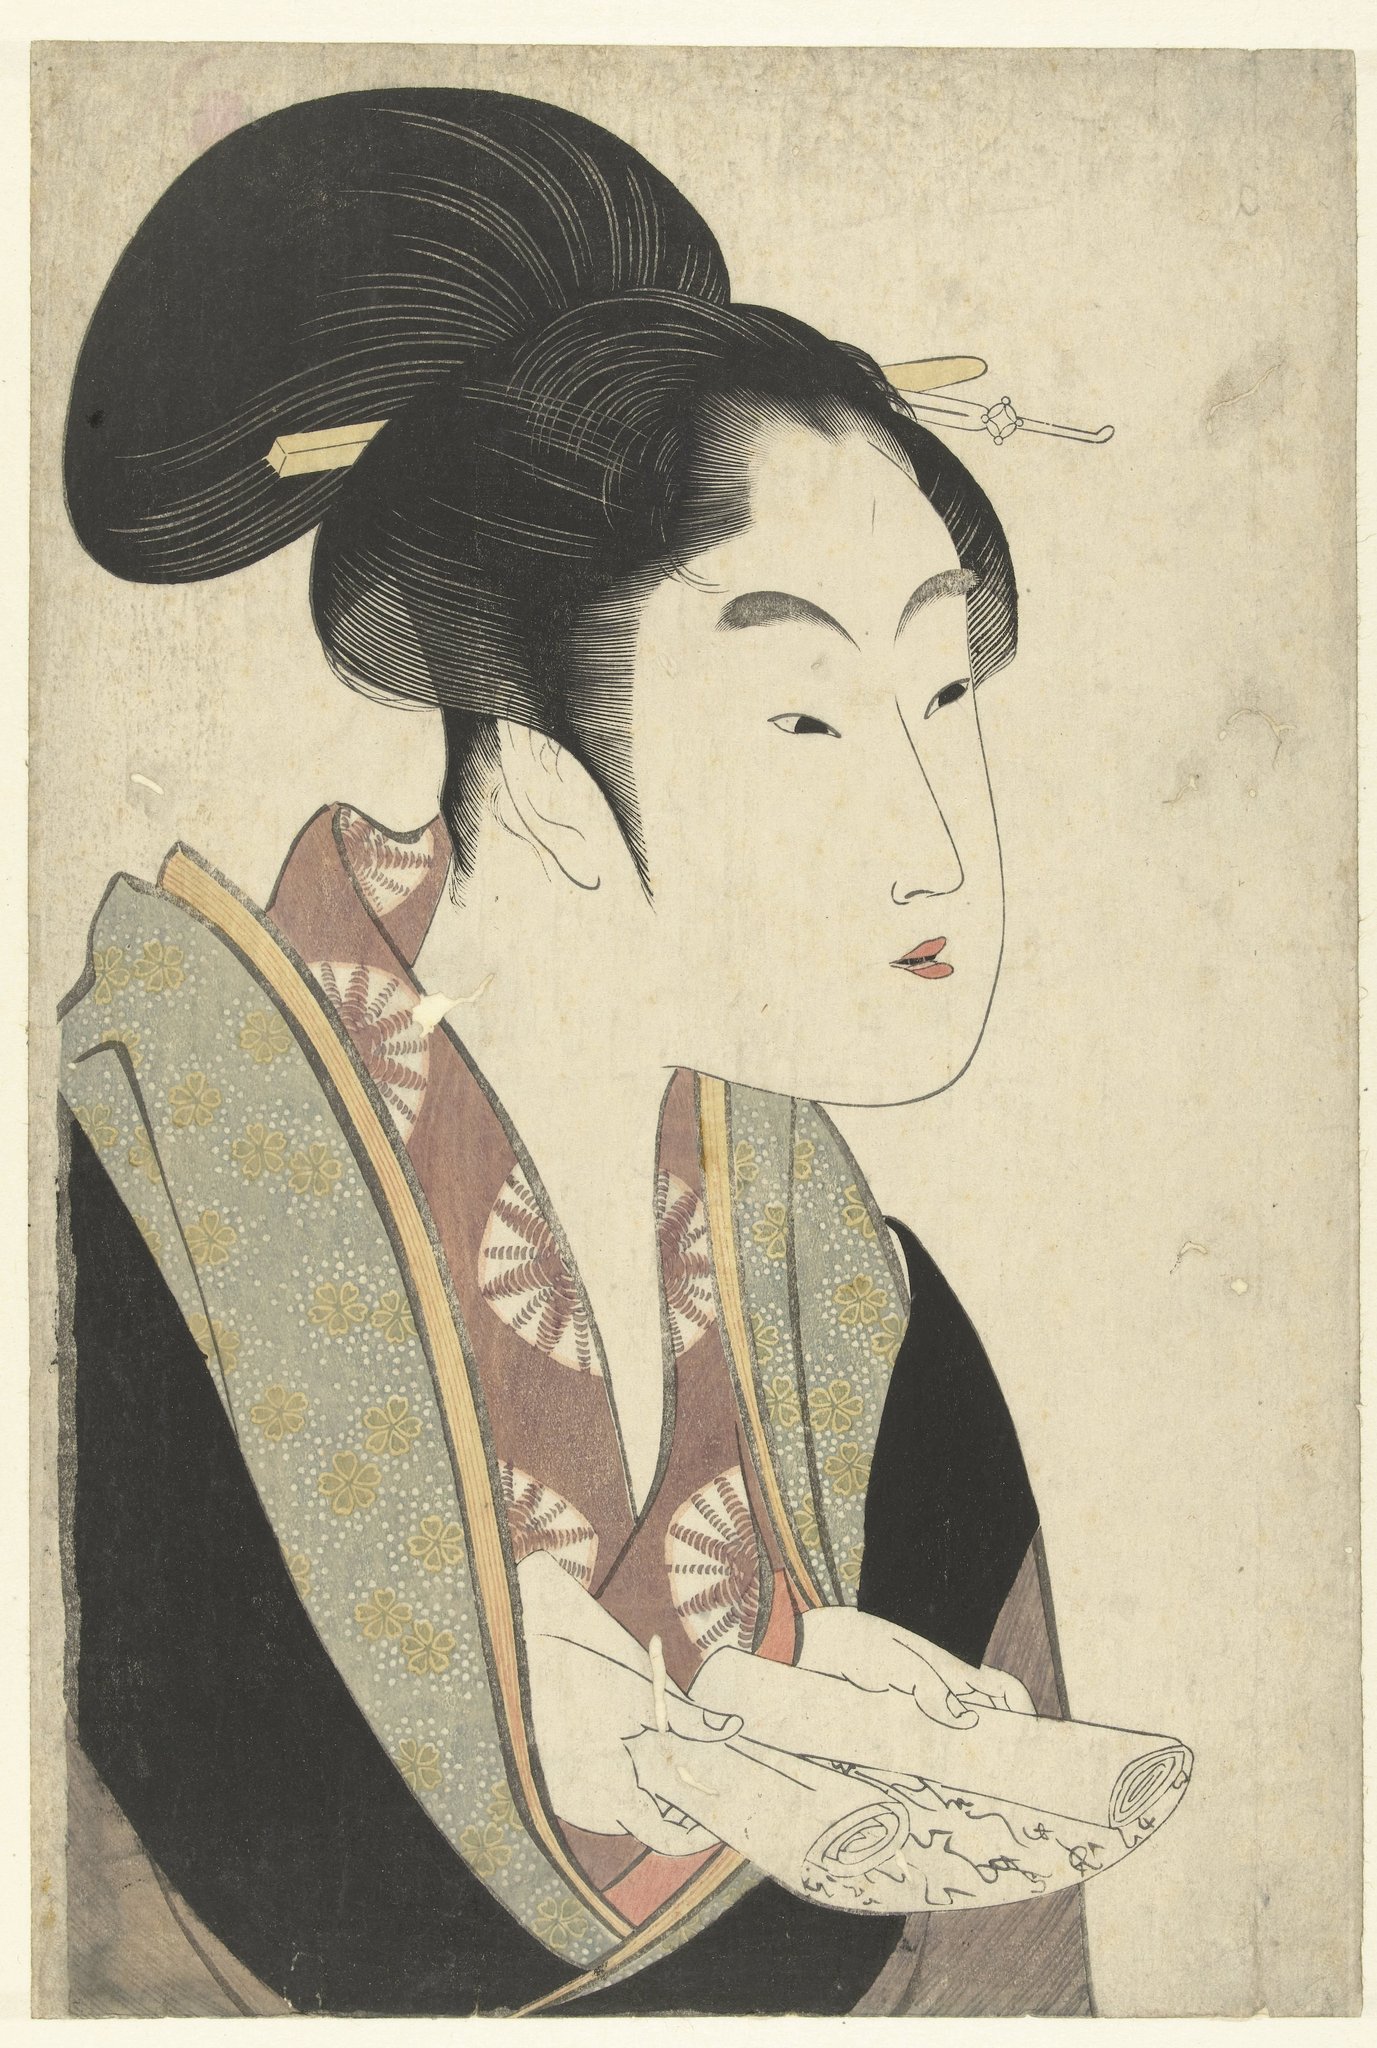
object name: print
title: Liefdesgedichten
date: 1792-1796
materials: paper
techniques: woodcut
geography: tokyo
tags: historical persons - bb - woman, lover with love-letter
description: Busteportret van jonge vrouw met liefdesbrief in handen.